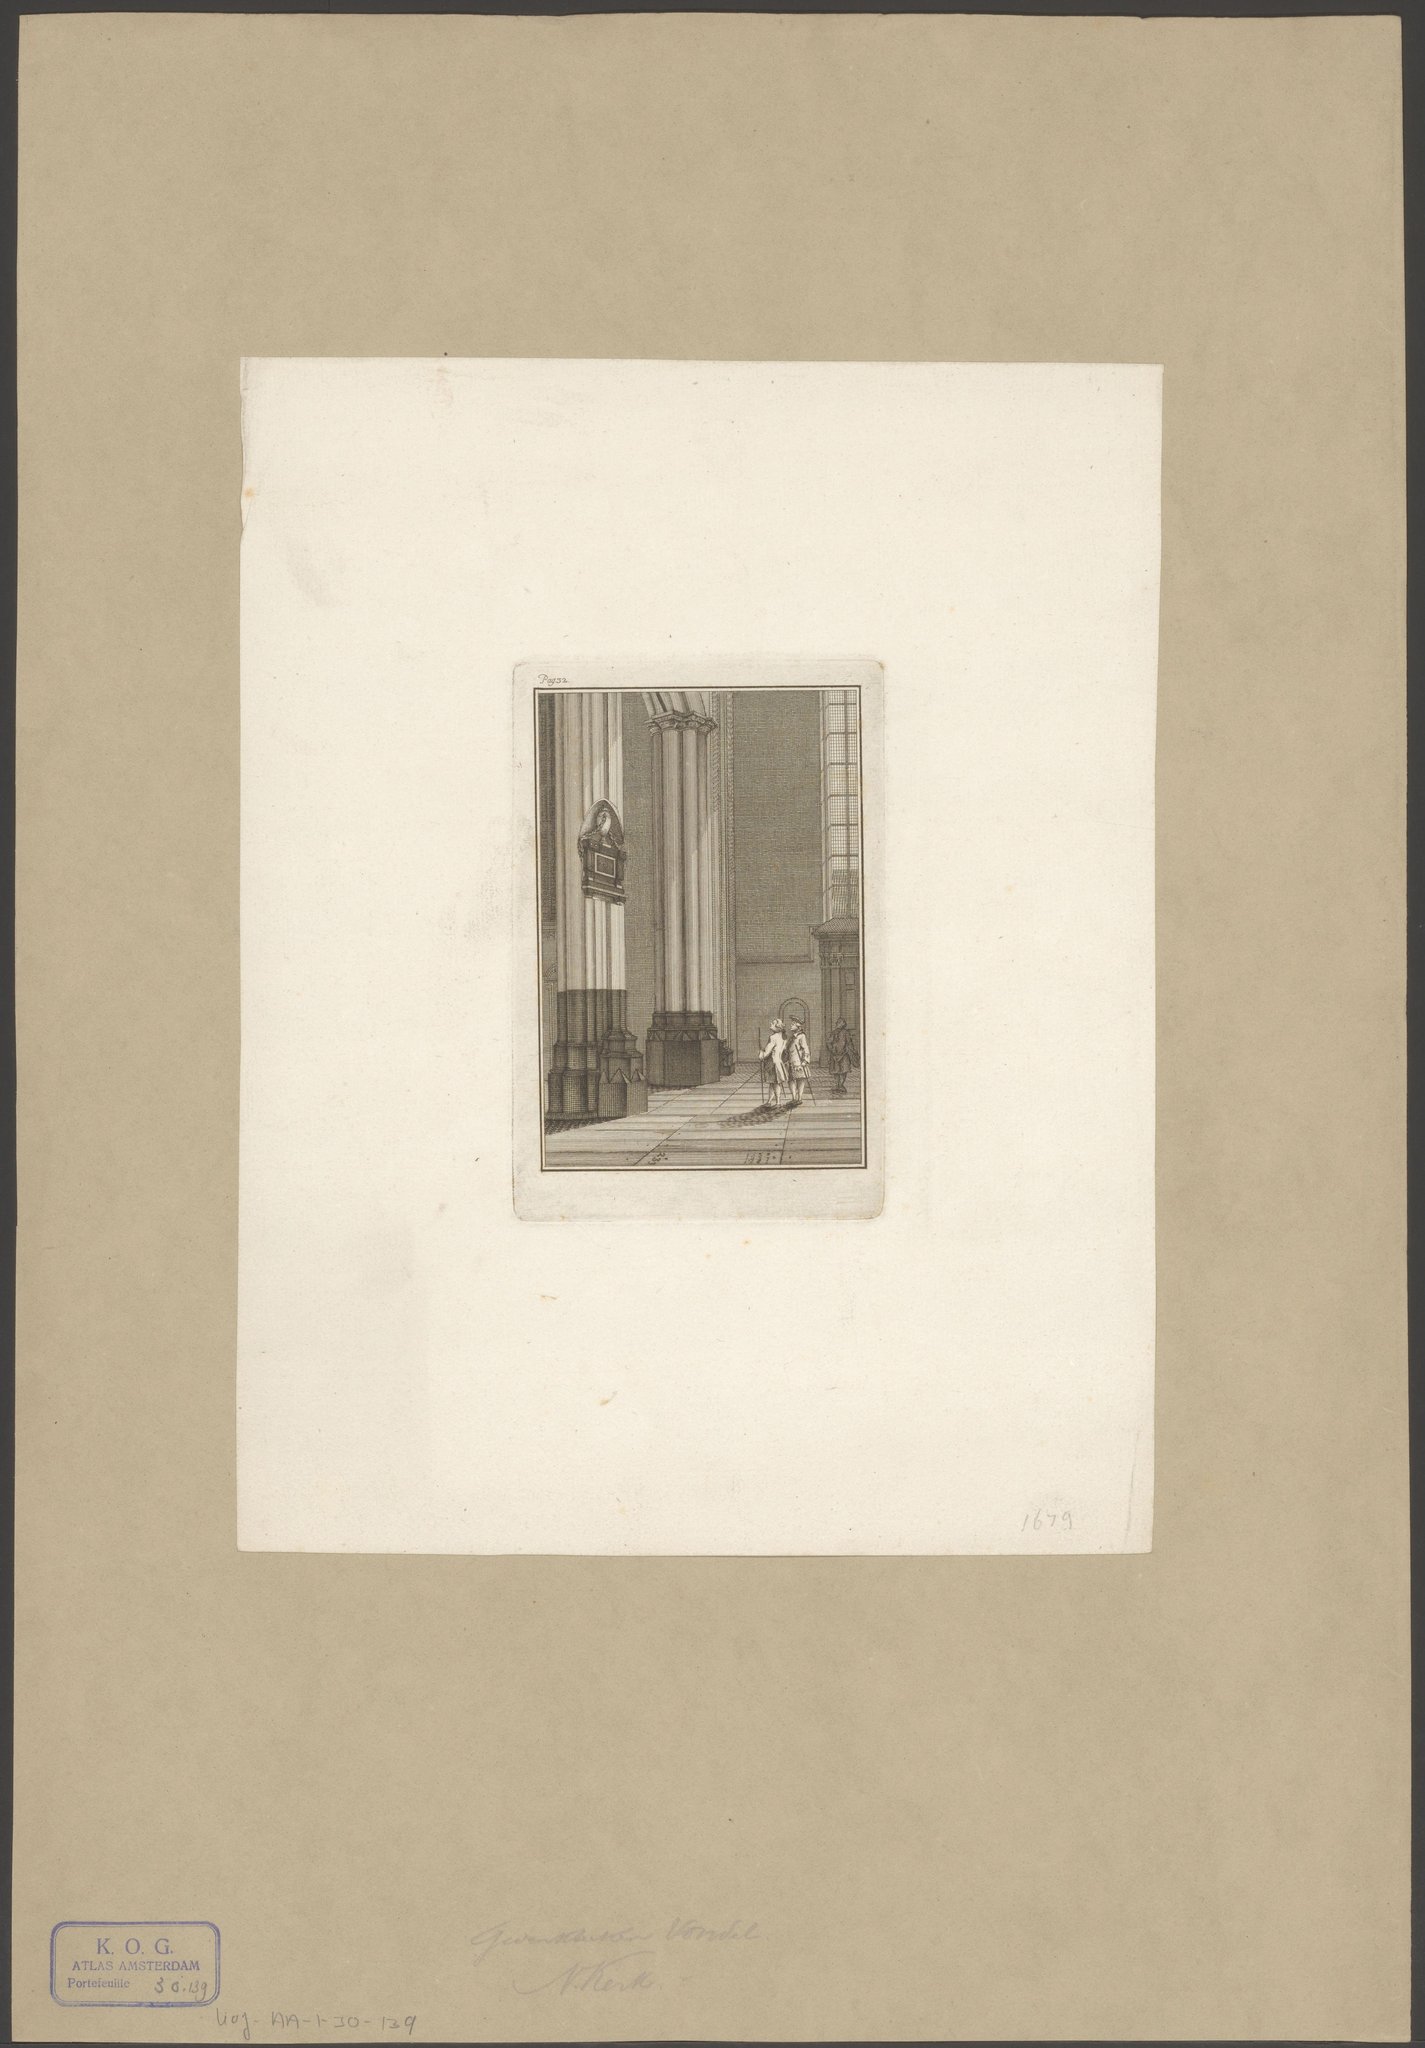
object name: print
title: Drie mannen bekijken het grafmonument van Joost van den Vondel in de Nieuwe Kerk te Amsterdam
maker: Anonymous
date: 1772-1800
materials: paper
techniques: etching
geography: northern netherlands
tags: interior of church, grave-building, monumental tomb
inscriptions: collector's mark: Lugt 1641b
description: Linksboven: Pag. 32. Onderwerpsrubriek binnen de Atlas Amsterdam: Kerkwezen: Hervormde Gemeente: Nieuwe Kerk van binnen.